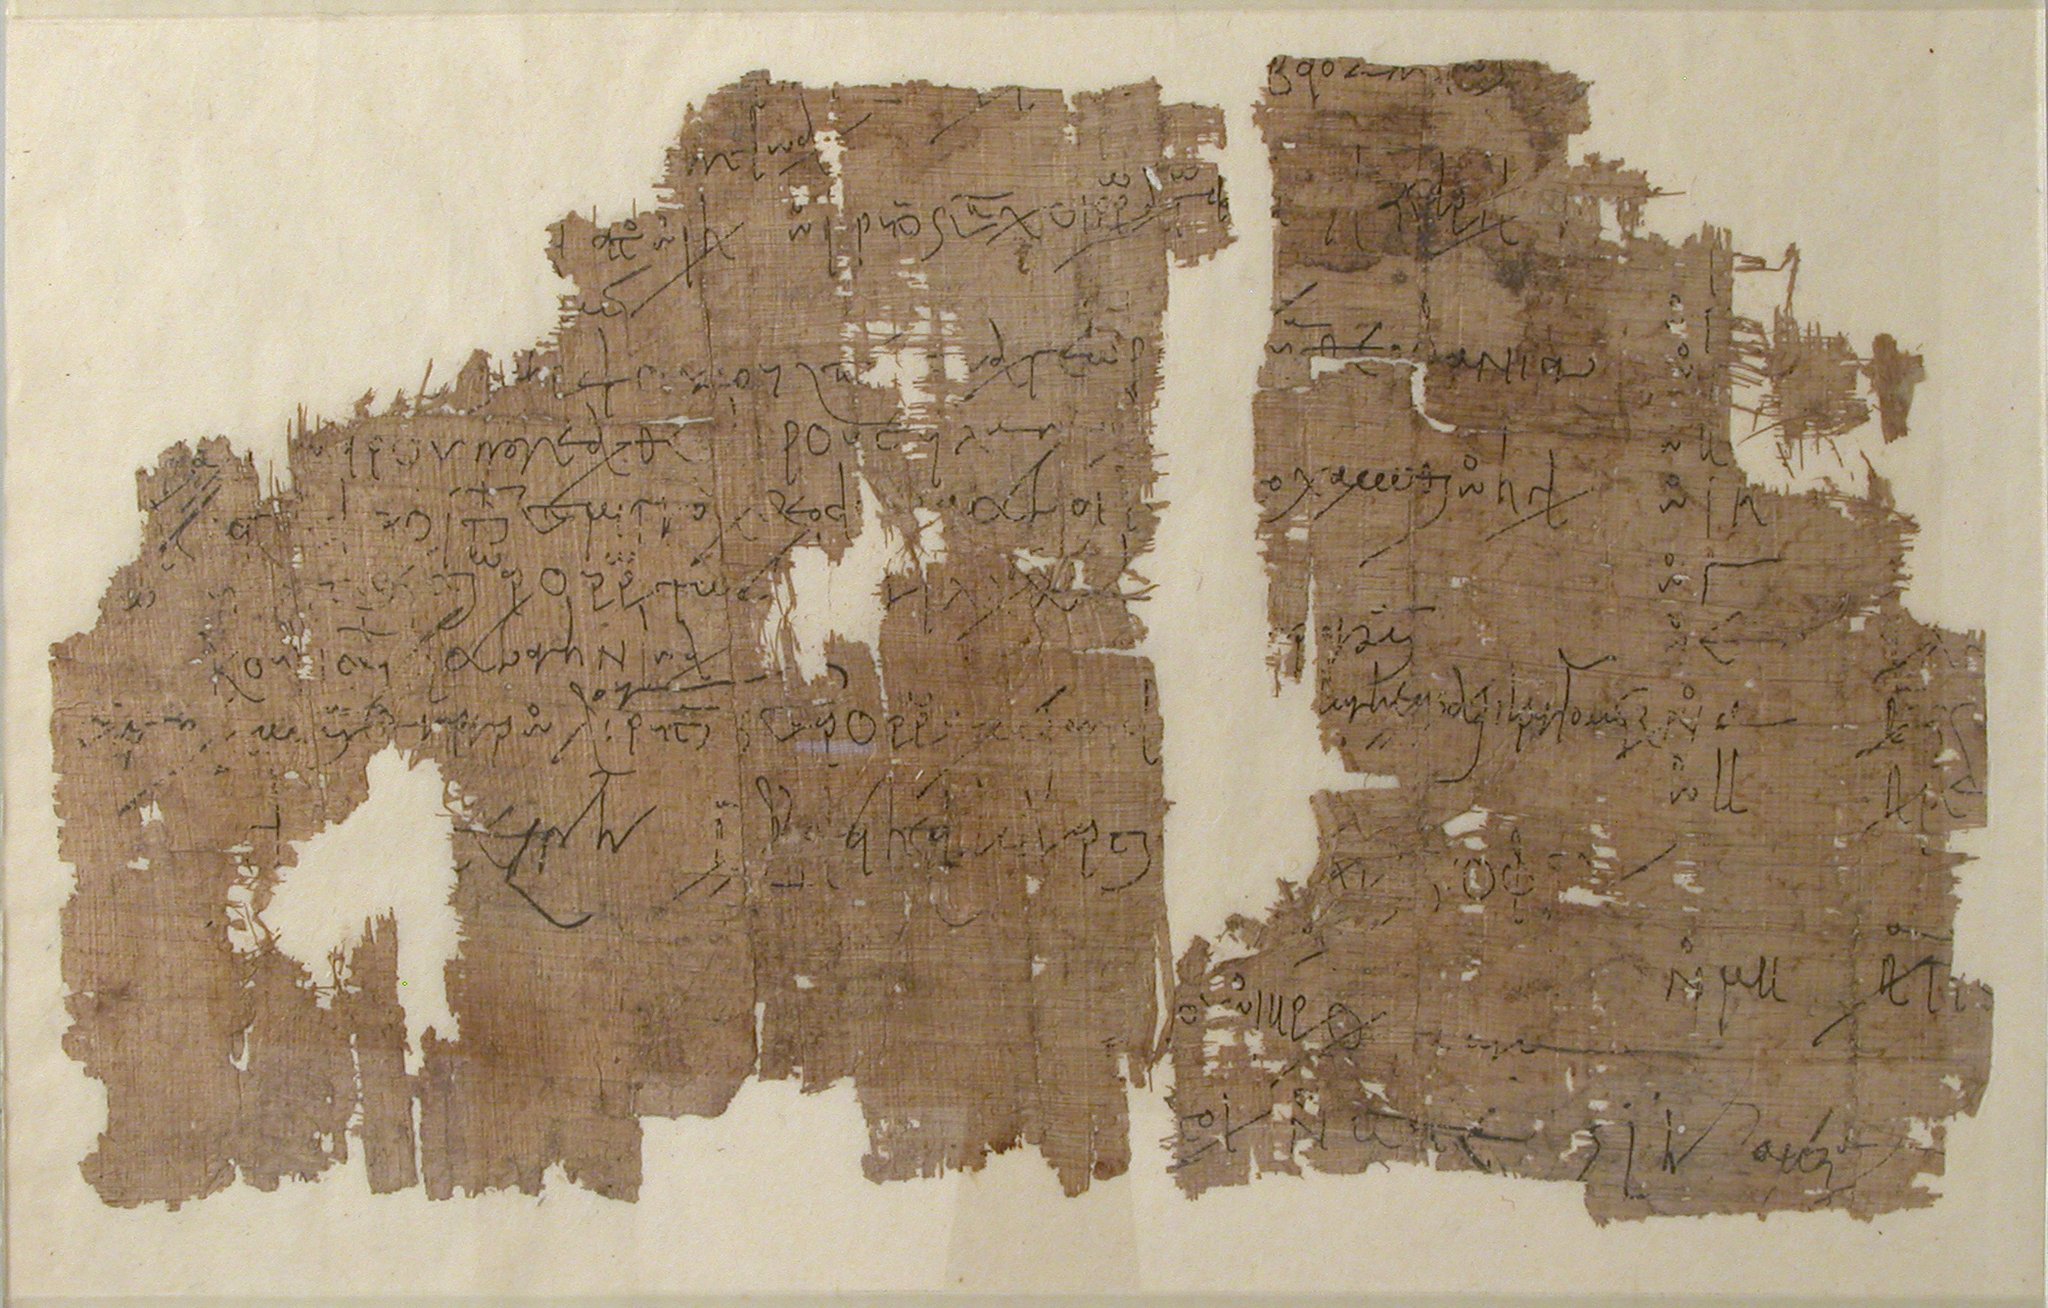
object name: papyrus fragment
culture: coptic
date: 501-700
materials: ink, papyrus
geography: egypt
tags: documents,greek